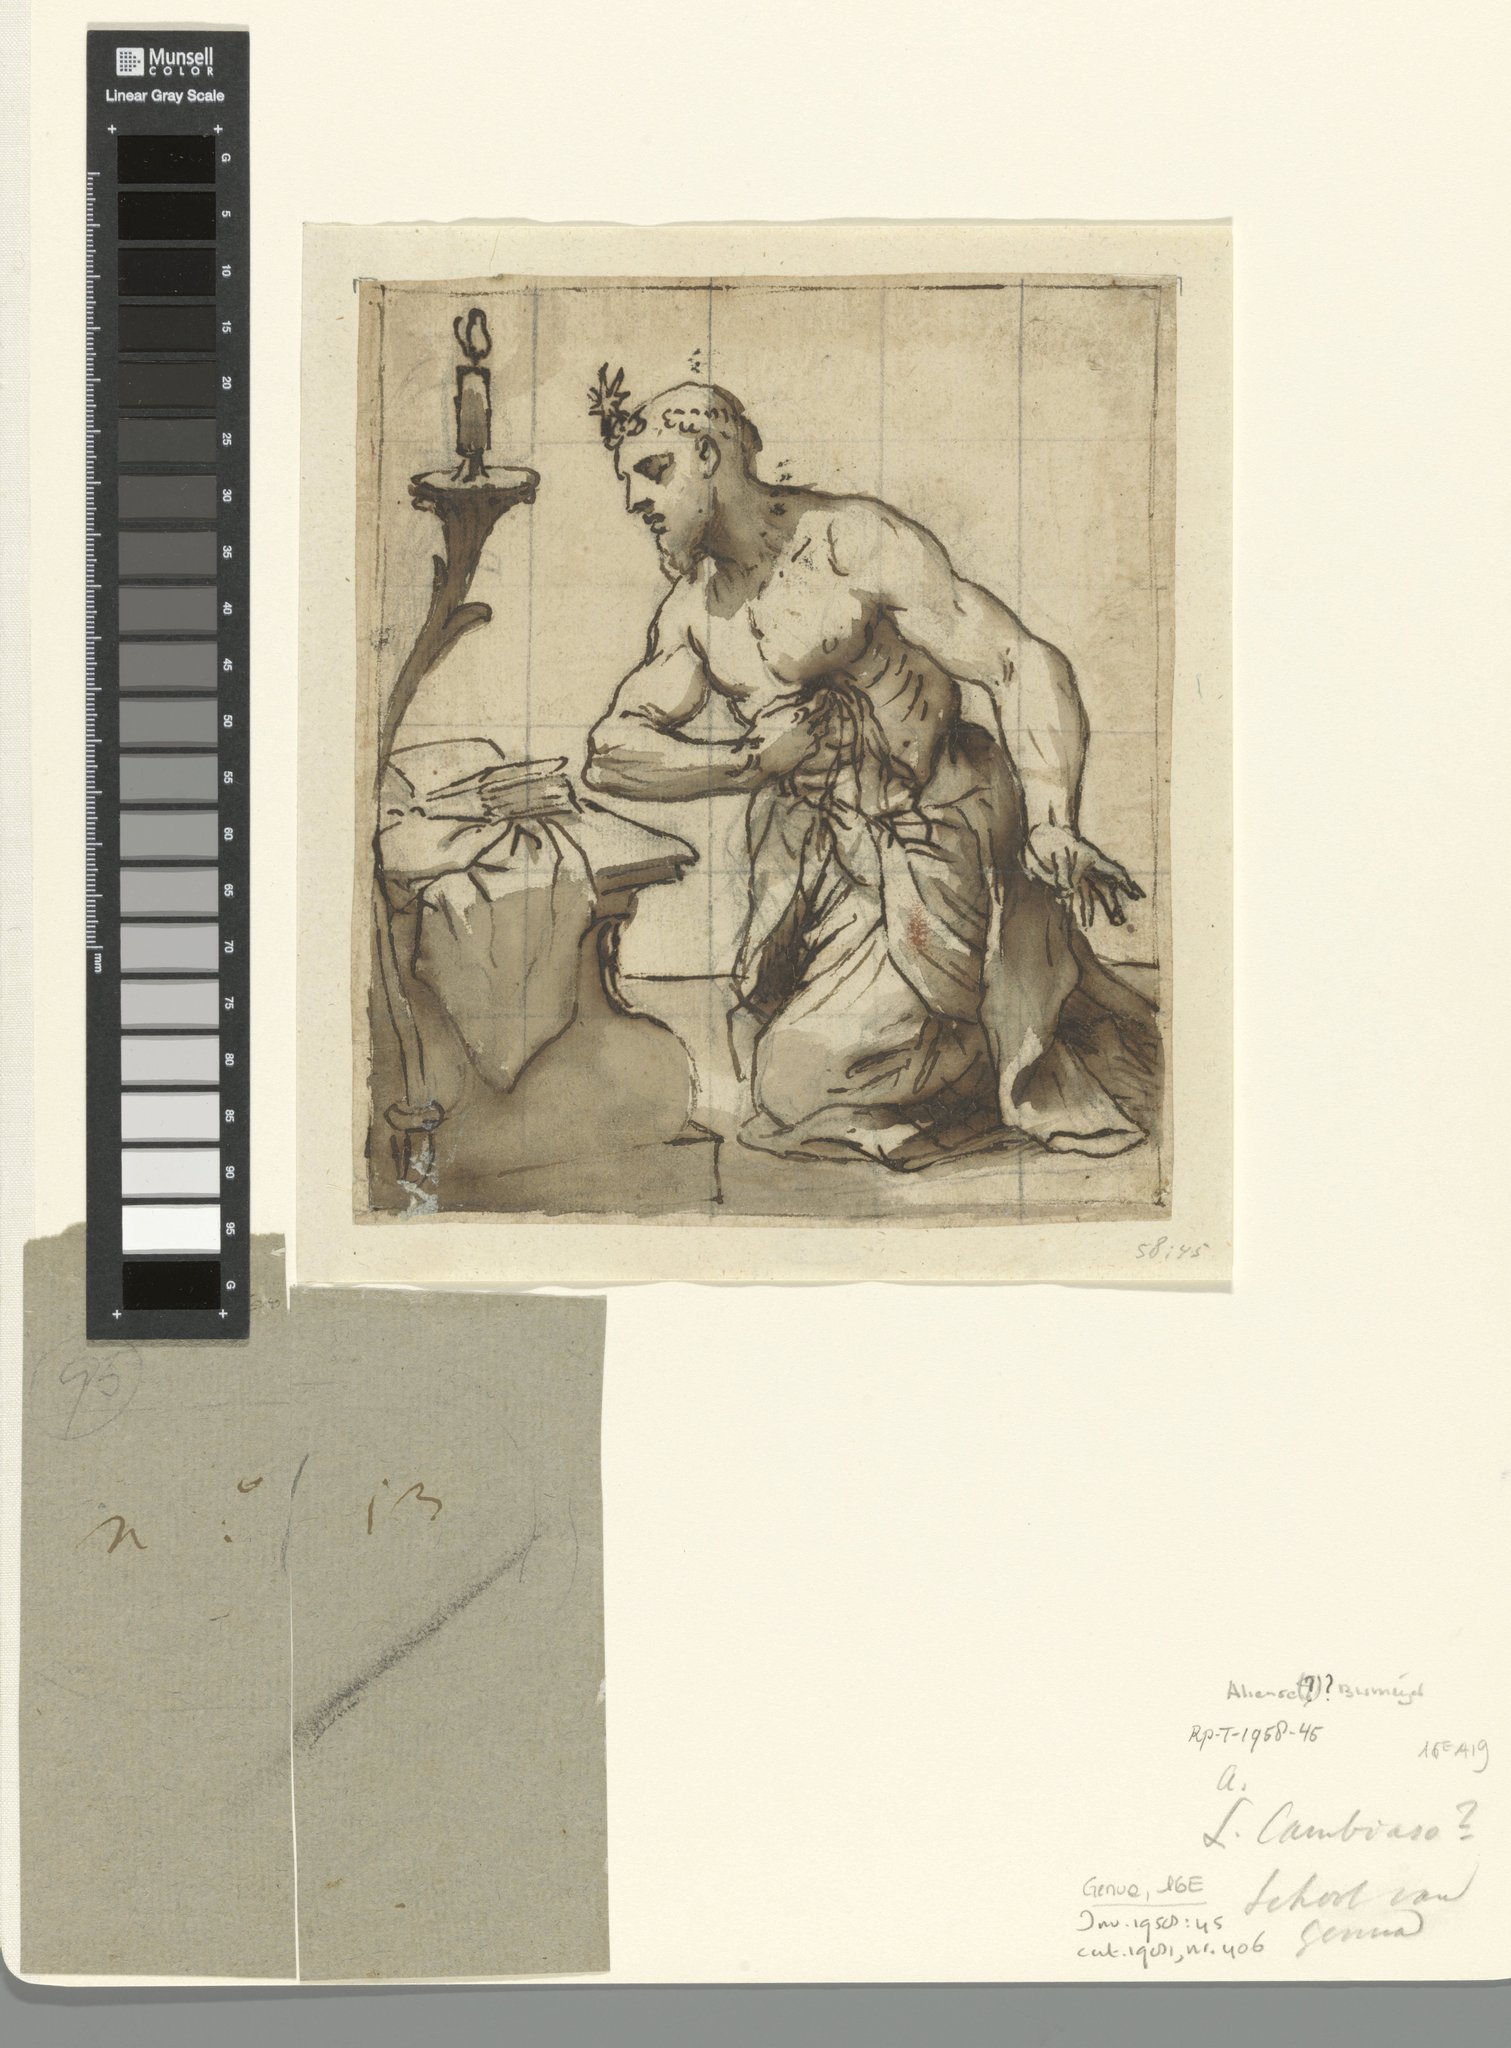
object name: drawing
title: Boetvaardige heilige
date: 1500-1599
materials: chalk, ink, paper, pencil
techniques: brush, pen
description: Boetvaardige heilige, geknield voor een boek bij een brandende kaars.